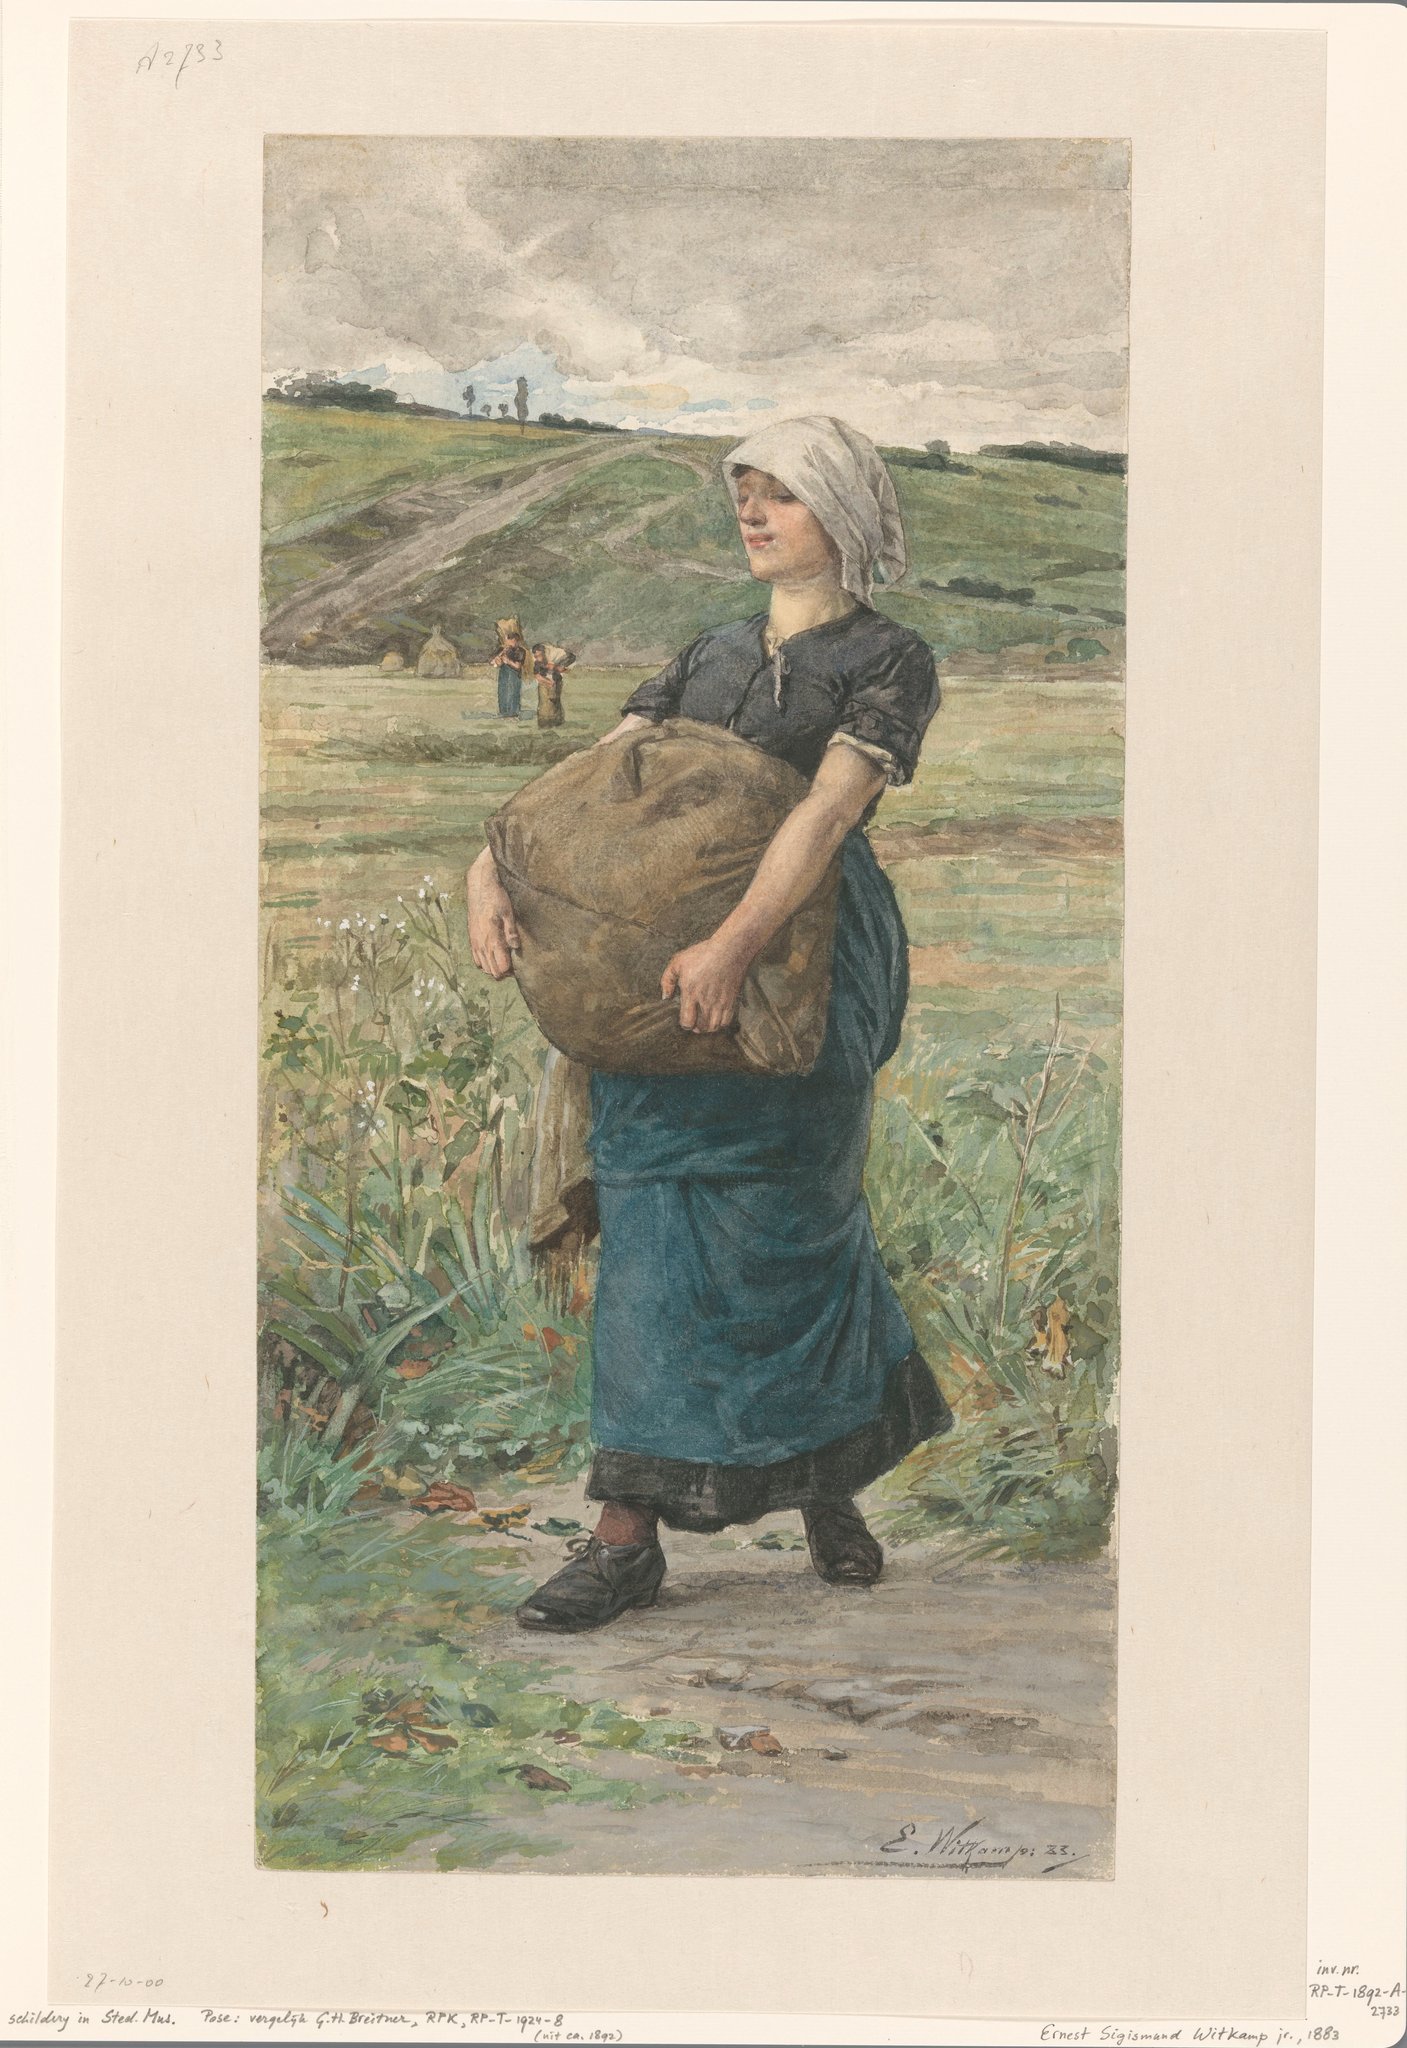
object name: drawing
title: Lopende vrouw met zware zak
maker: ernst witkamp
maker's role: draughtsman, print maker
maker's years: 1854-1897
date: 1883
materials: paper, watercolor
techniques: brush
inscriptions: date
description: Schilderij in Stedelijk Museum Amsterdam.